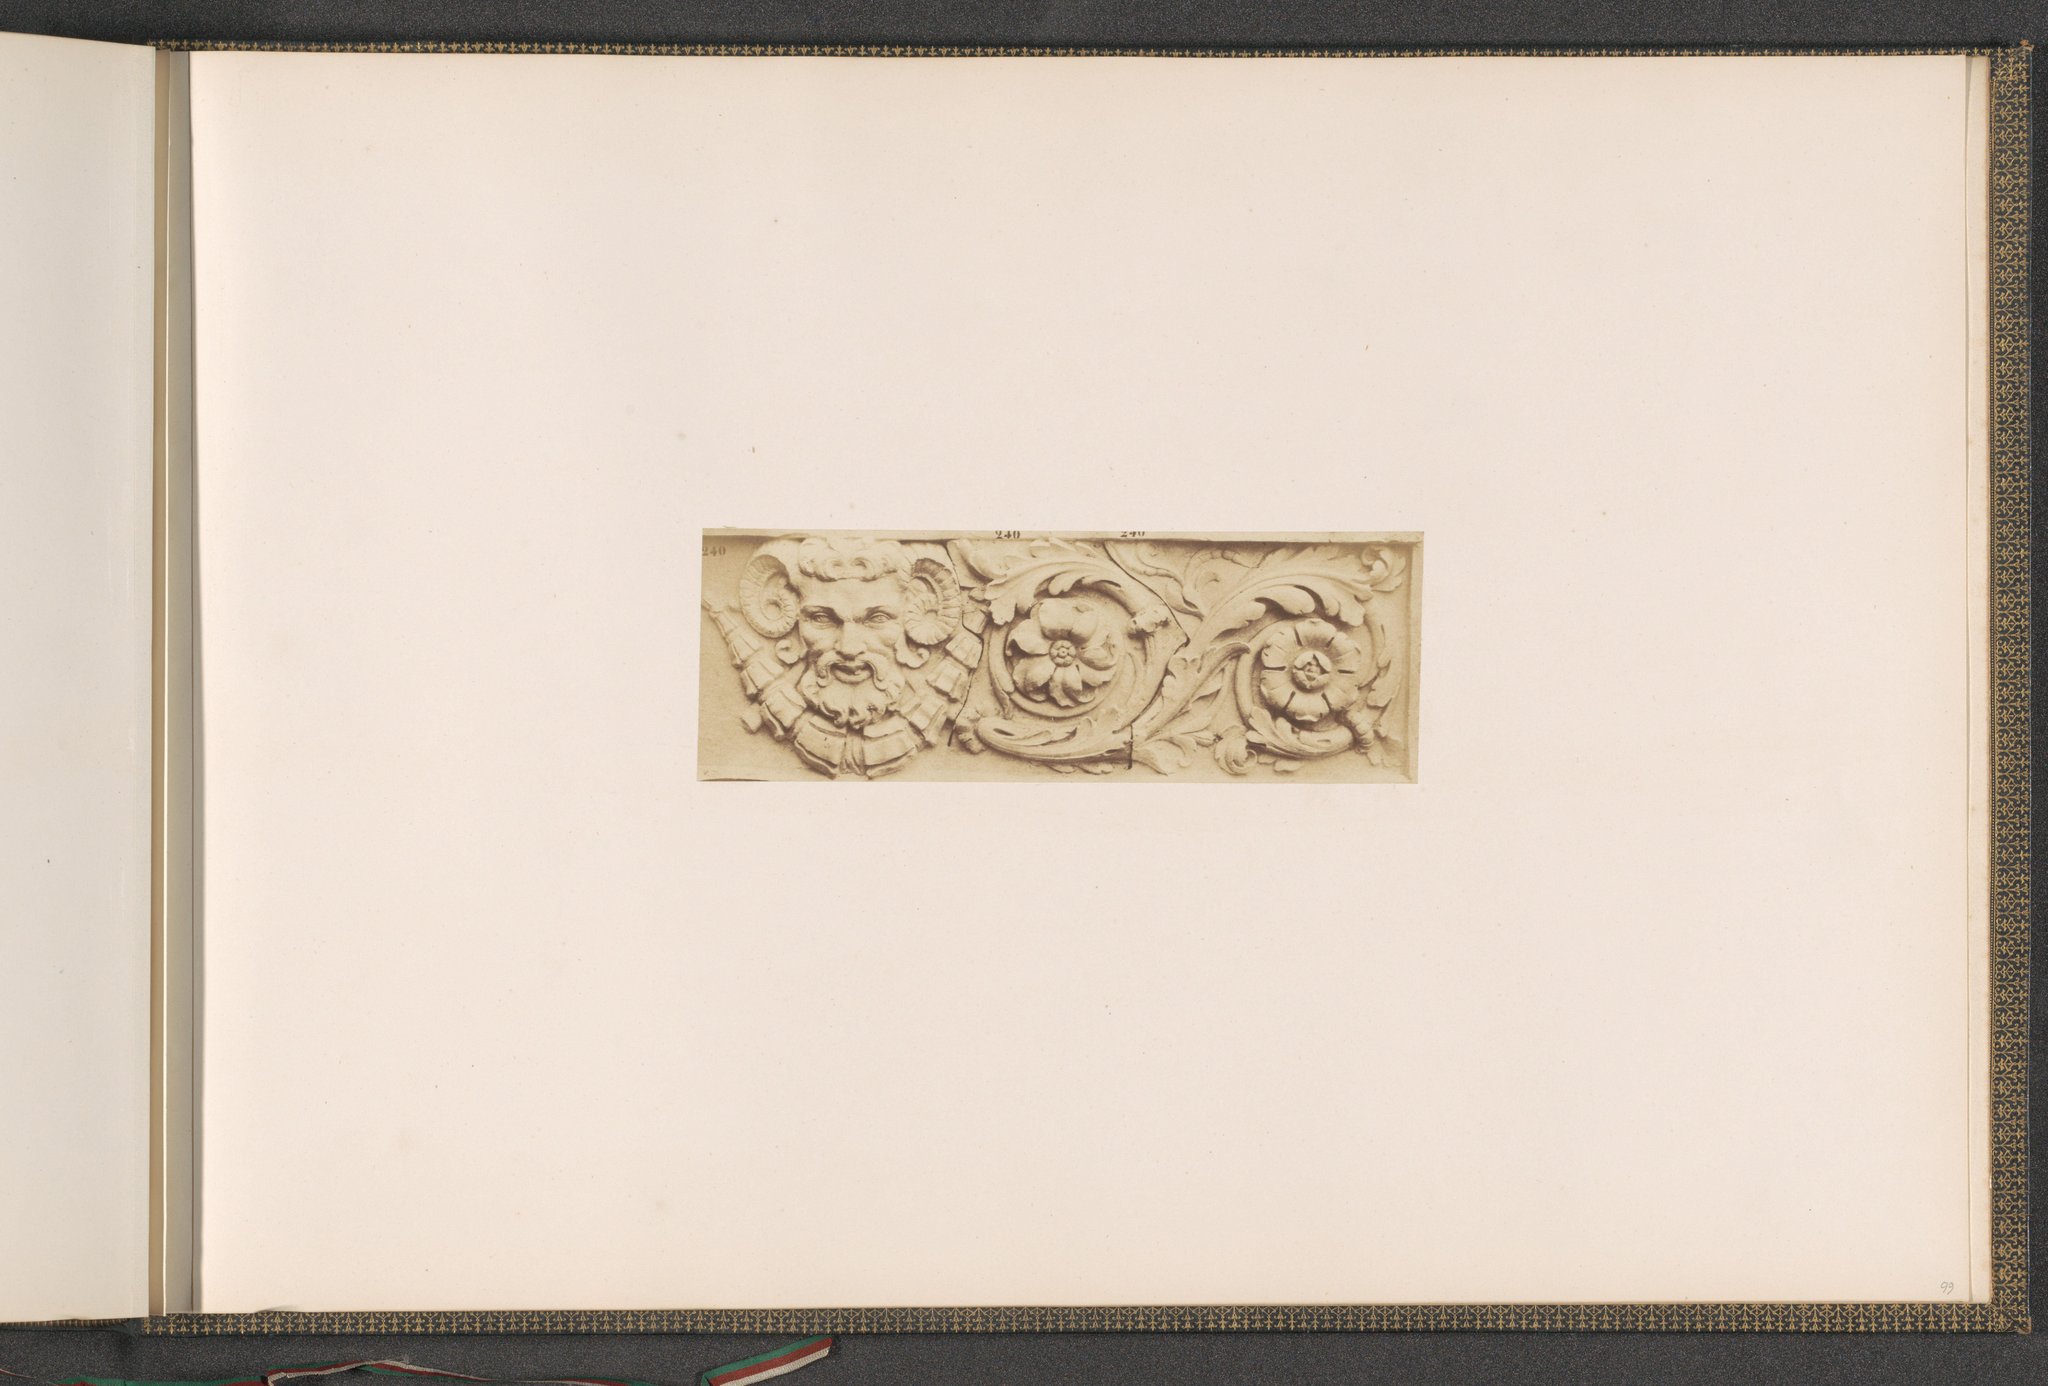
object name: photograph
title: Gipsmodel voor een friesversiering op het Palais du Louvre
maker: édouard denis baldus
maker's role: fotograaf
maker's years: 1813-1889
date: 1855-1857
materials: paper, photographic support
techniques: salted paper print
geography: paris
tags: permanent exhibition, museum, ornamenting, decorating ~ applied arts, paris, tuileries palace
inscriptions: number: ‘240’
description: Onderdeel van Réunion des Tuileries au Louvre 1852-1857, album 4.